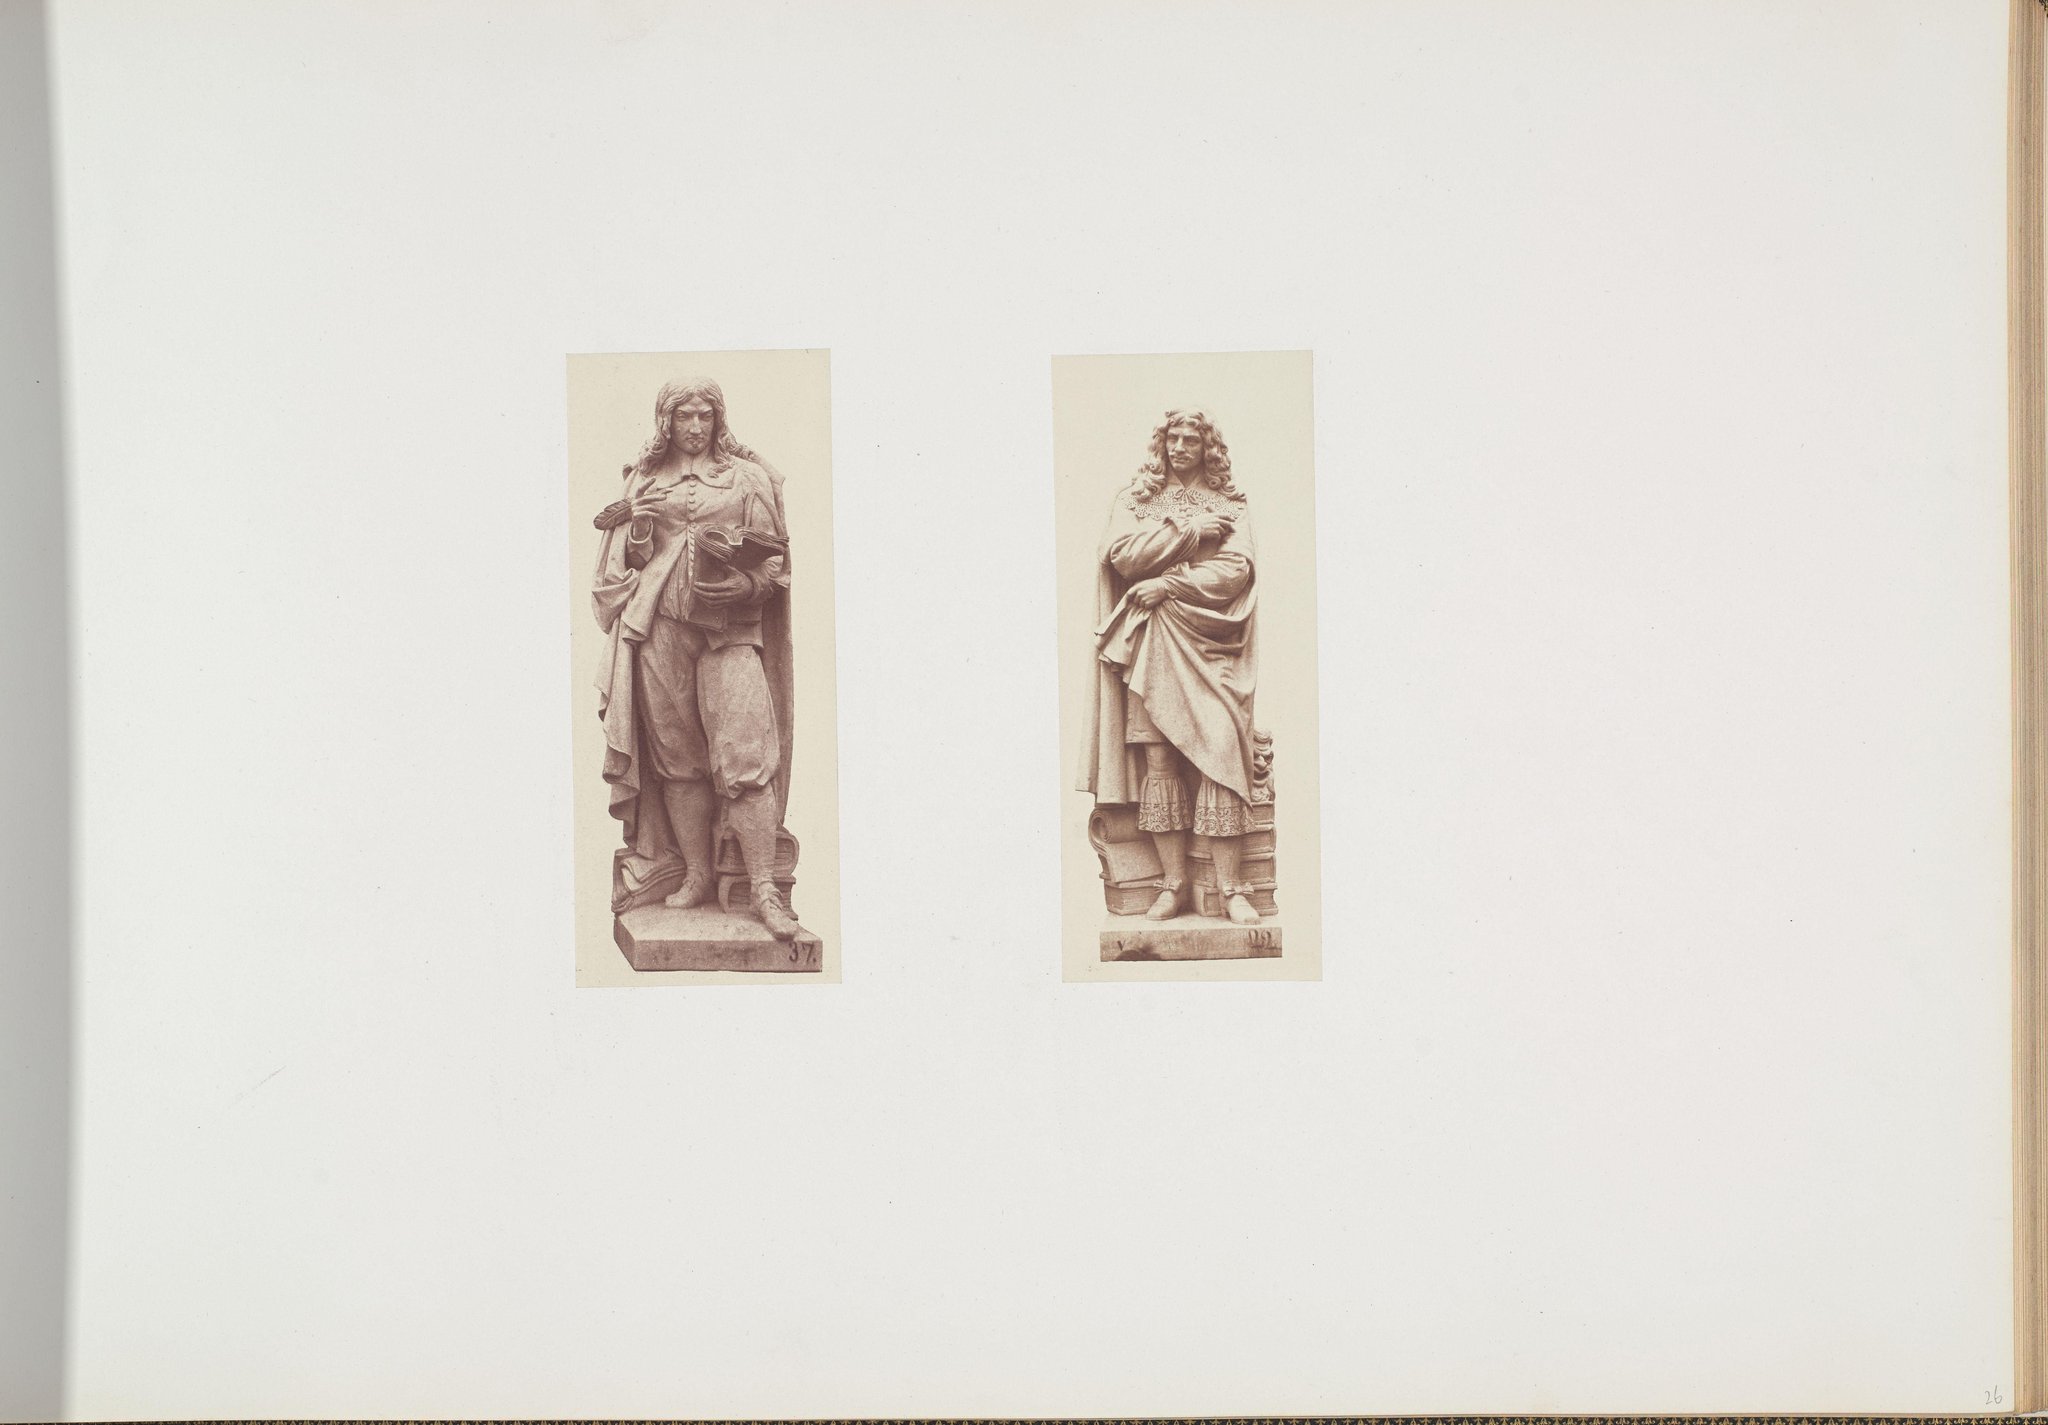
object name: album leaf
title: Gipsmodellen voor beeldhouwwerken op het Palais du Louvre: links "Mézeray" door Louis Joseph Daumas en rechts "Molière" door Gabriel Bernard Seurre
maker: édouard denis baldus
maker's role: fotograaf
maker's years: 1813-1889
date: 1855-1857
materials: paper, photographic support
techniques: salted paper print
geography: paris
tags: piece of sculpture, reproduction of a piece of sculpture, permanent exhibition, museum, paris, tuileries palace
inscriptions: number: ‘37 en V 22’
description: Onderdeel van Réunion des Tuileries au Louvre 1852-1857, album 1.